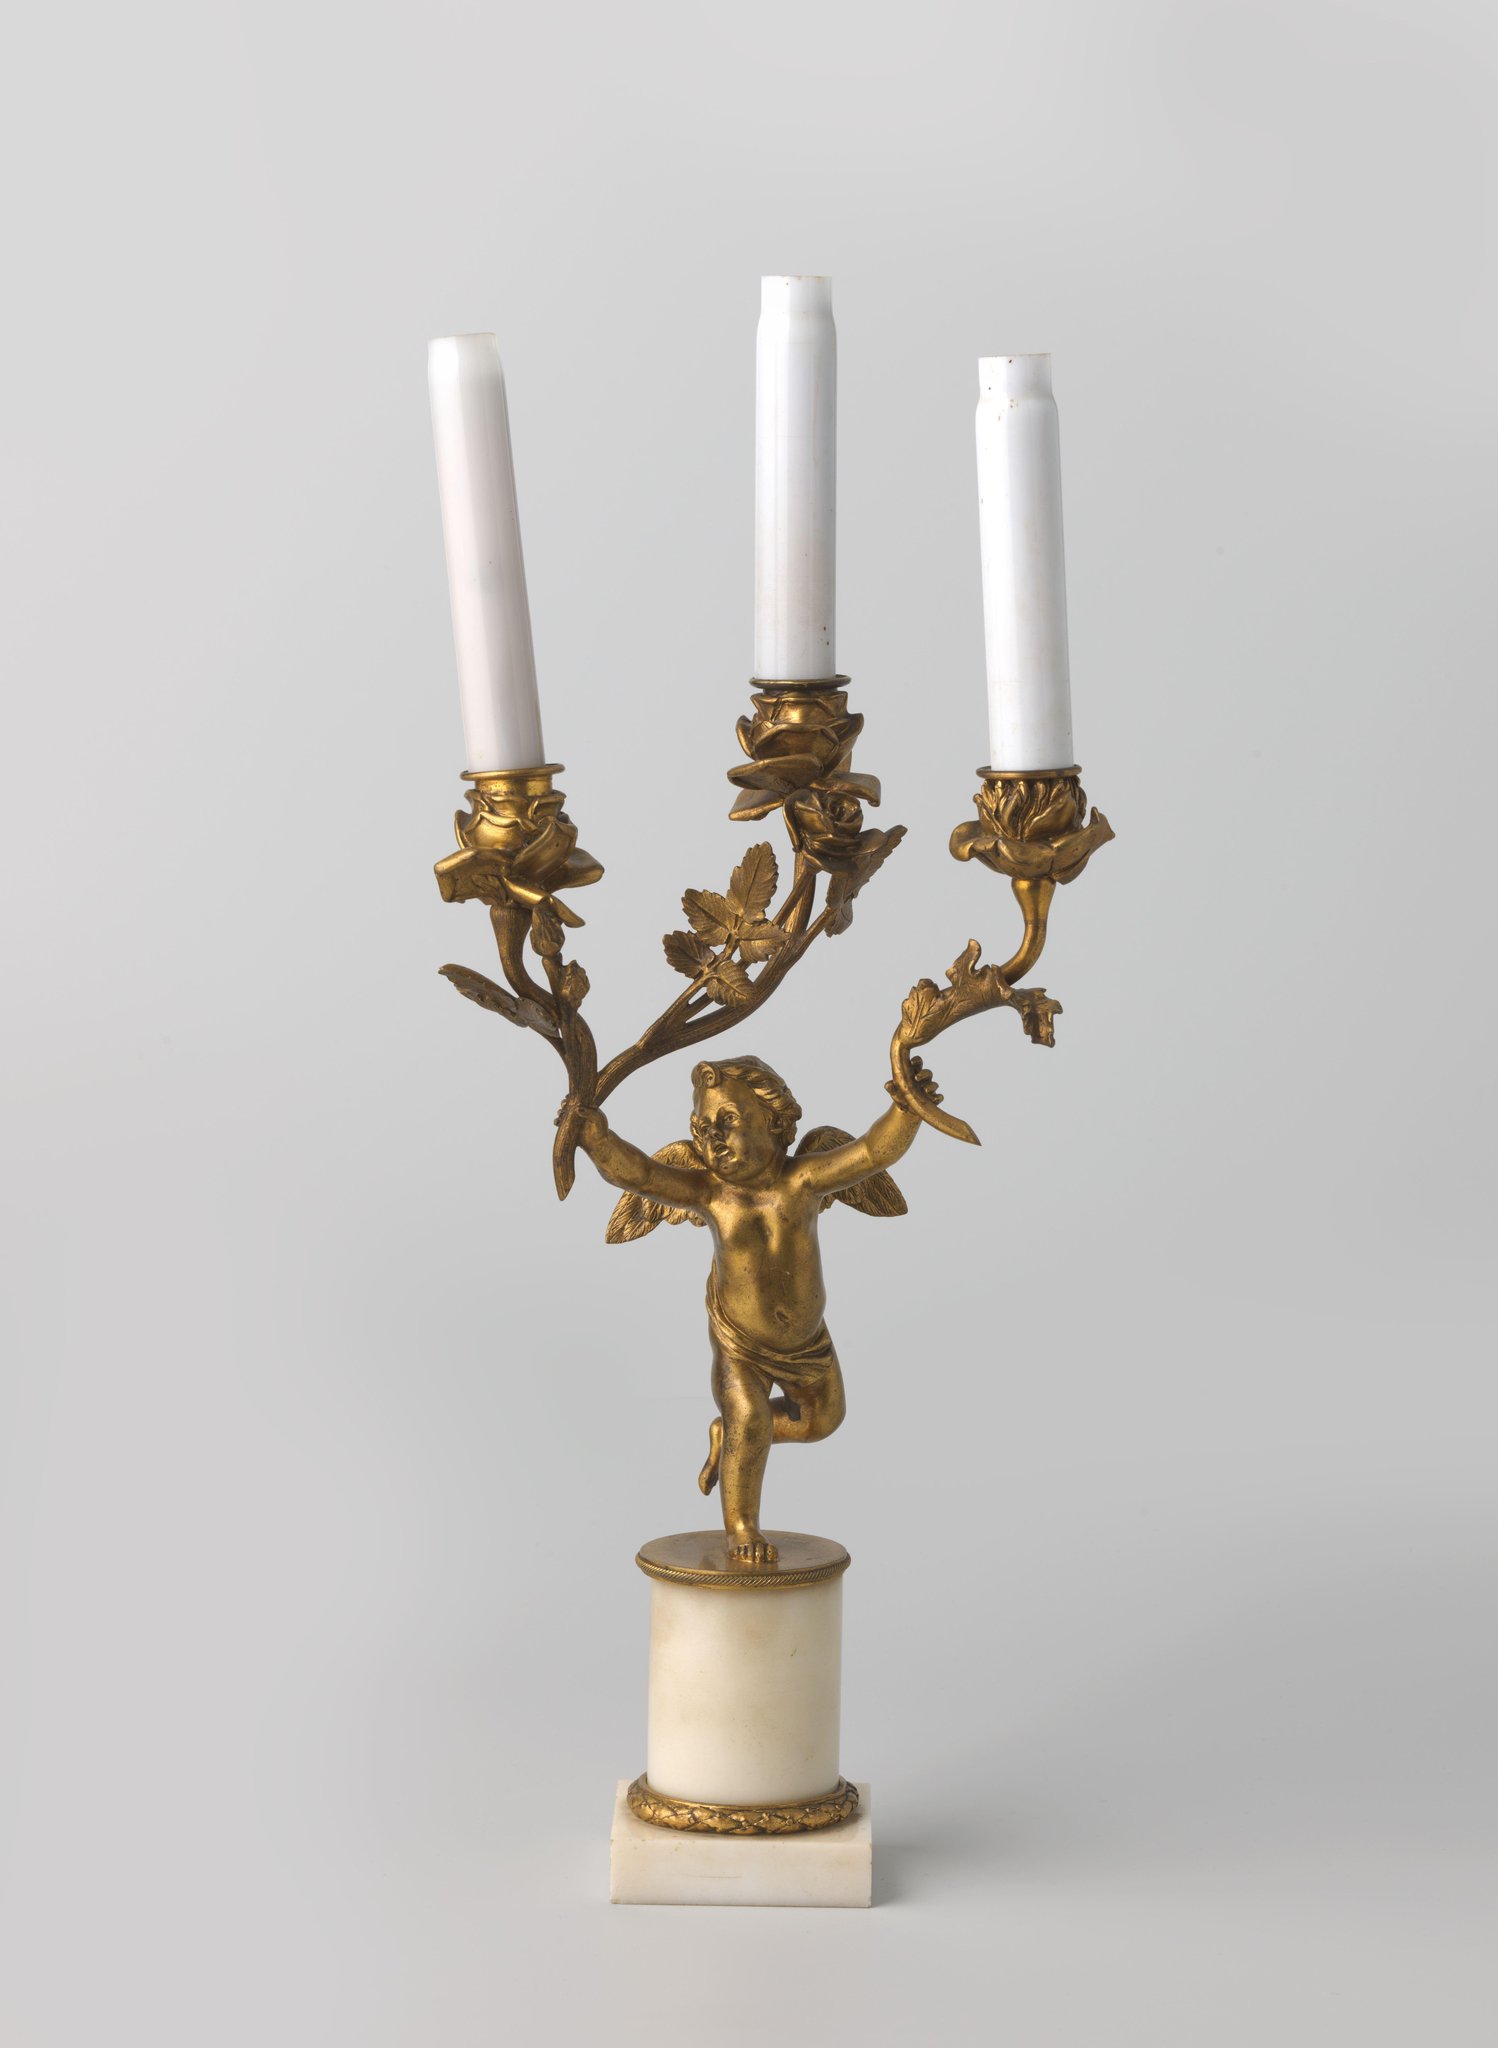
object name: candelabrum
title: Kandelaber van wit marmer en verguld brons, met drie armen in de vorm van takken met bladeren, eindigend in rozeknoppen, opgehouden door gevleugelde putto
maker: Anonymous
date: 1900-1915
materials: bronze, glass, marble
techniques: gilding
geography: france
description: Kandelaber van wit marmer en verguld brons, met drie armen in de vorm van takken met bladeren, eindigend in rozeknoppen die als kaarsenhouder dienst doen. Ze worden opgehouden door een gevleugelde putto. Het voetstuk bestaat uit een ronde trommel, rustend op een vierkant plintstuk. De kandelaber is ingericht voor elektriciteit. Zie tevens: BK-1978-47-B.